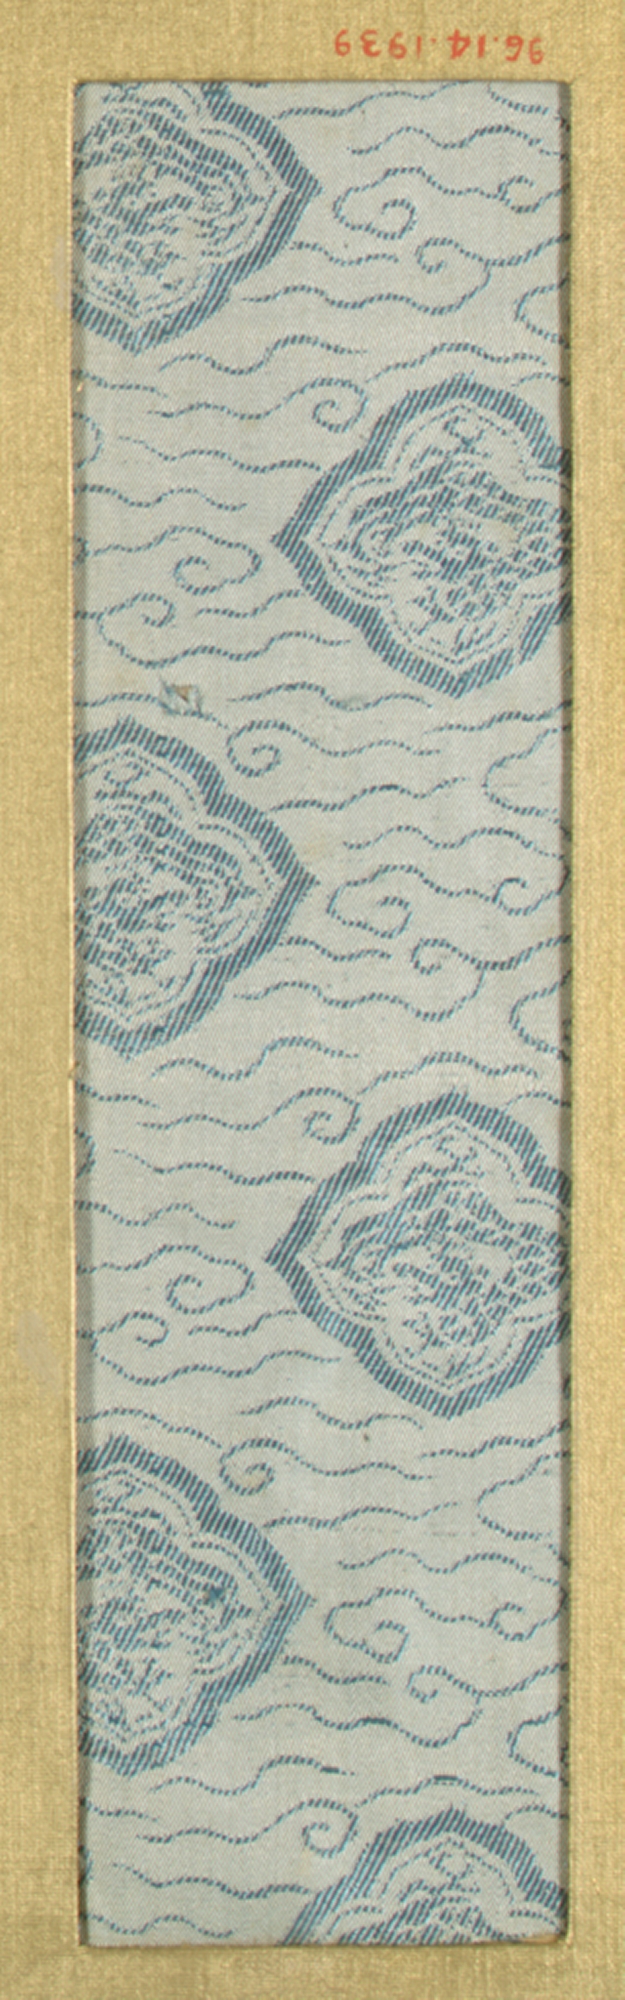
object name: piece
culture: japanese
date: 1701-1900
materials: silk